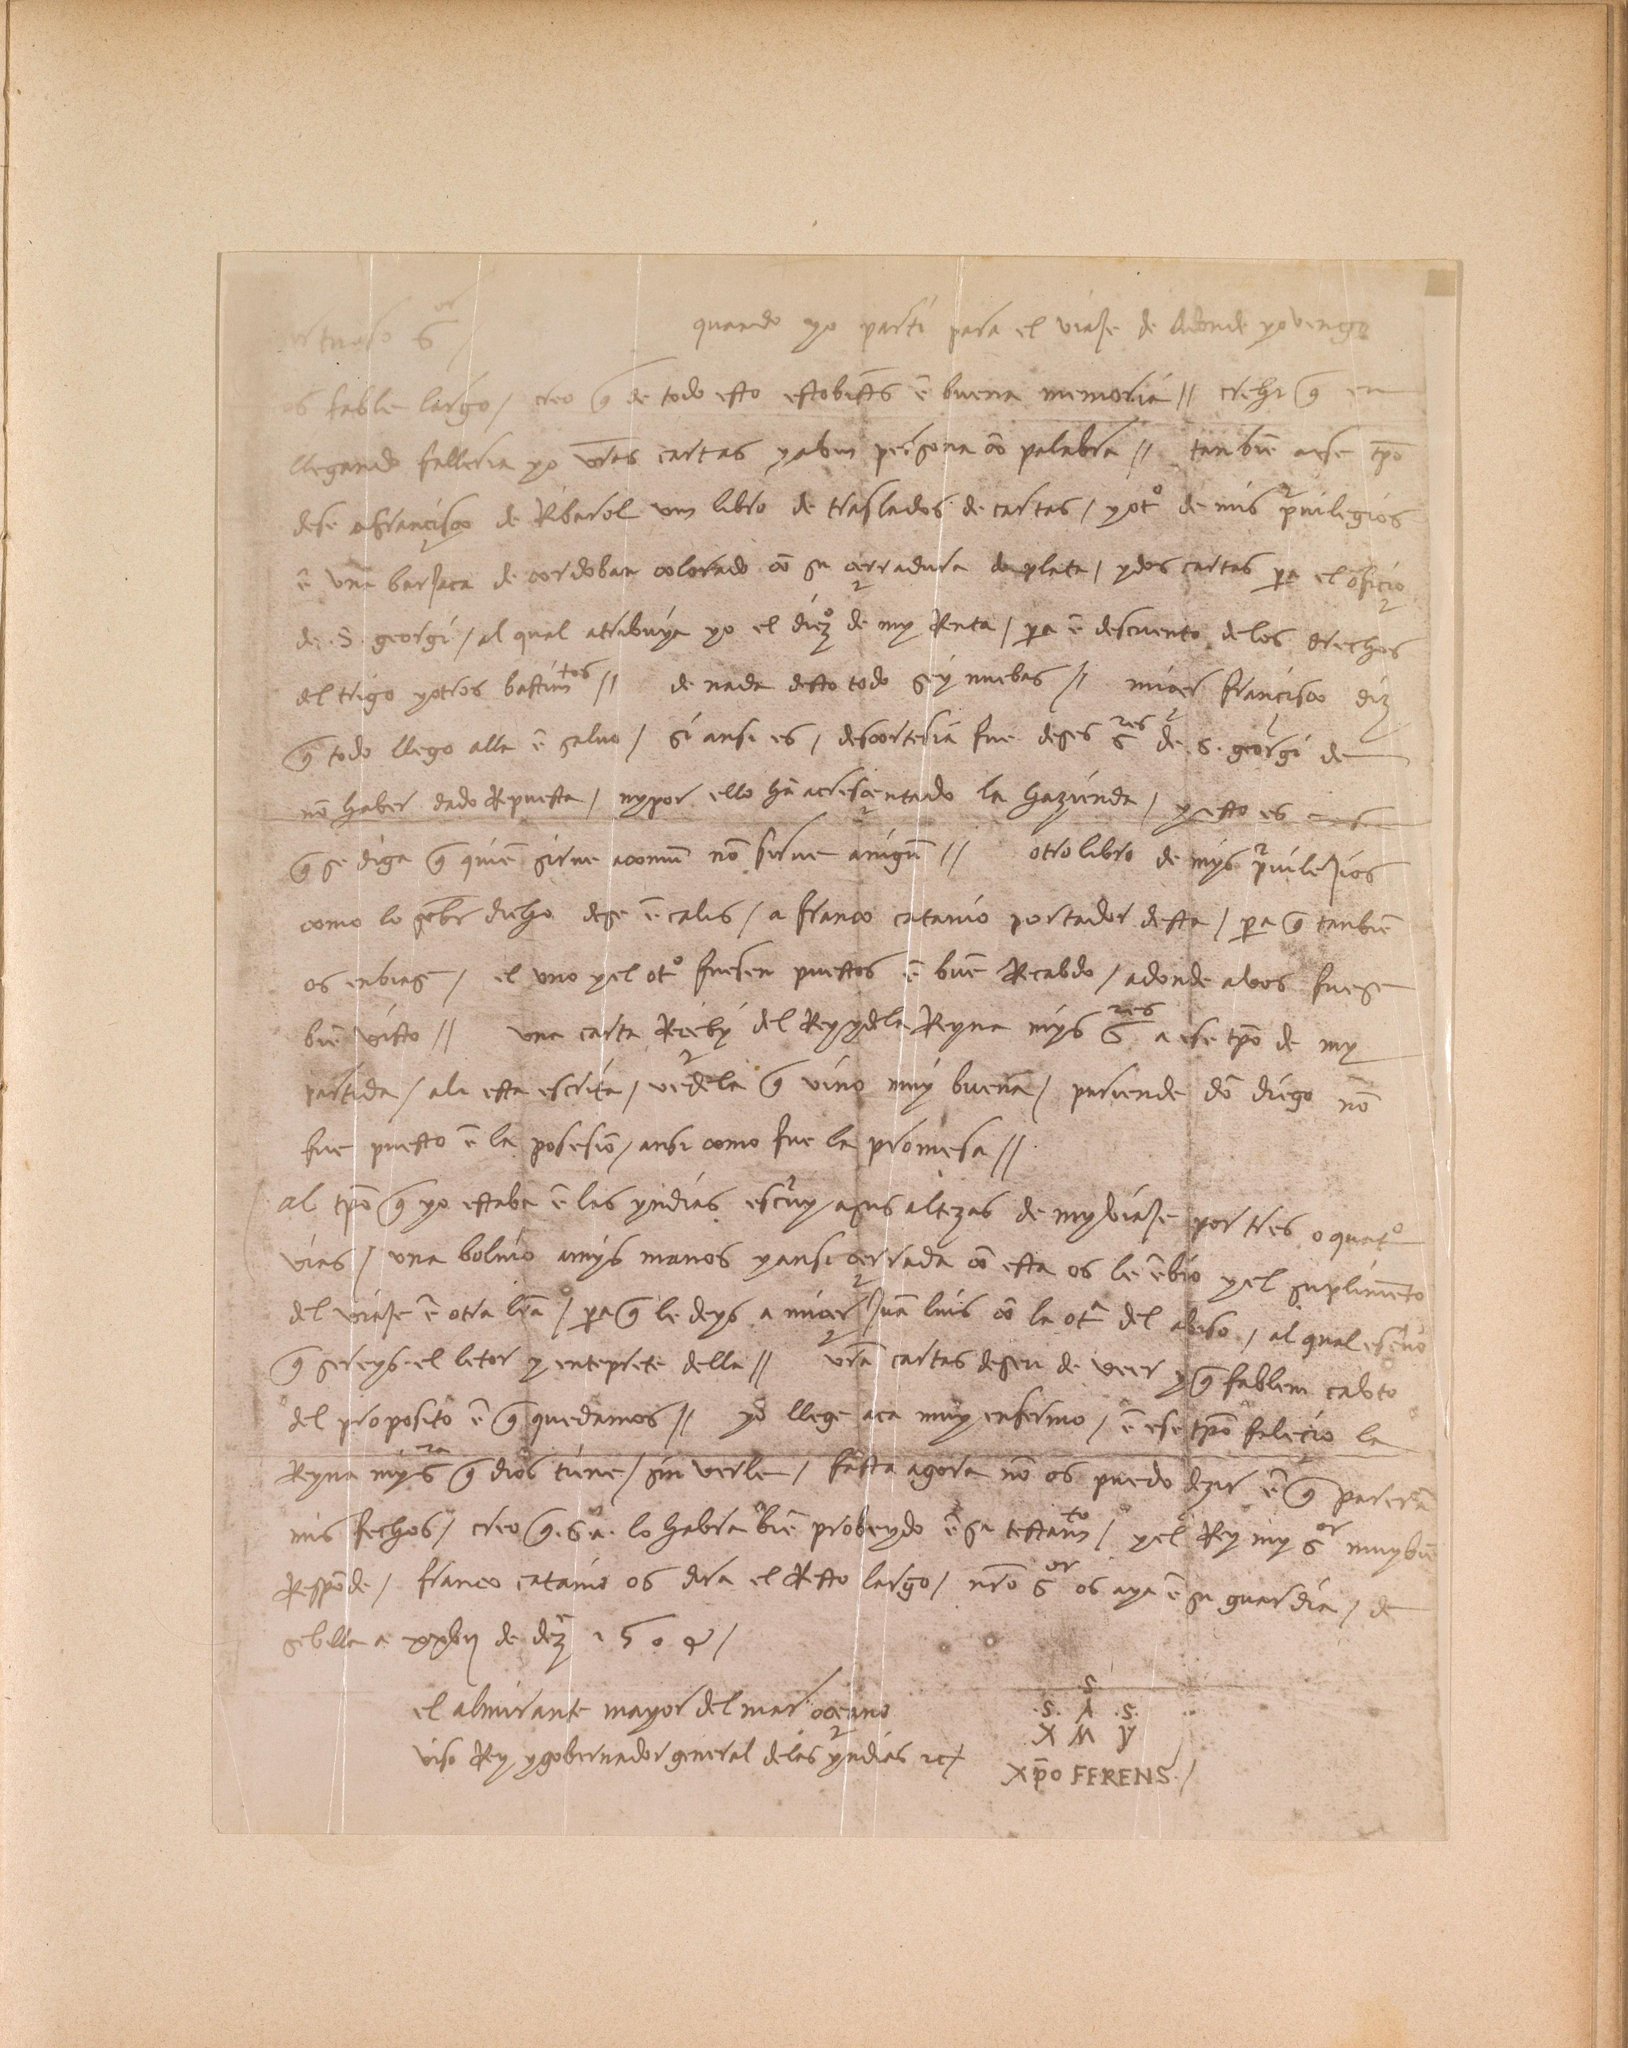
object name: album leaf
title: Fotoreproductie van een brief uit (vermoedelijk) 1509, geschreven door Christoffel Columbus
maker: Anonymous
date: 1870-1900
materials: paper, photographic support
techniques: albumen print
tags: letter, envelope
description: Onderdeel van Reisalbum met foto's van bezienswaardigheden in Italië en Zuid-Frankrijk.